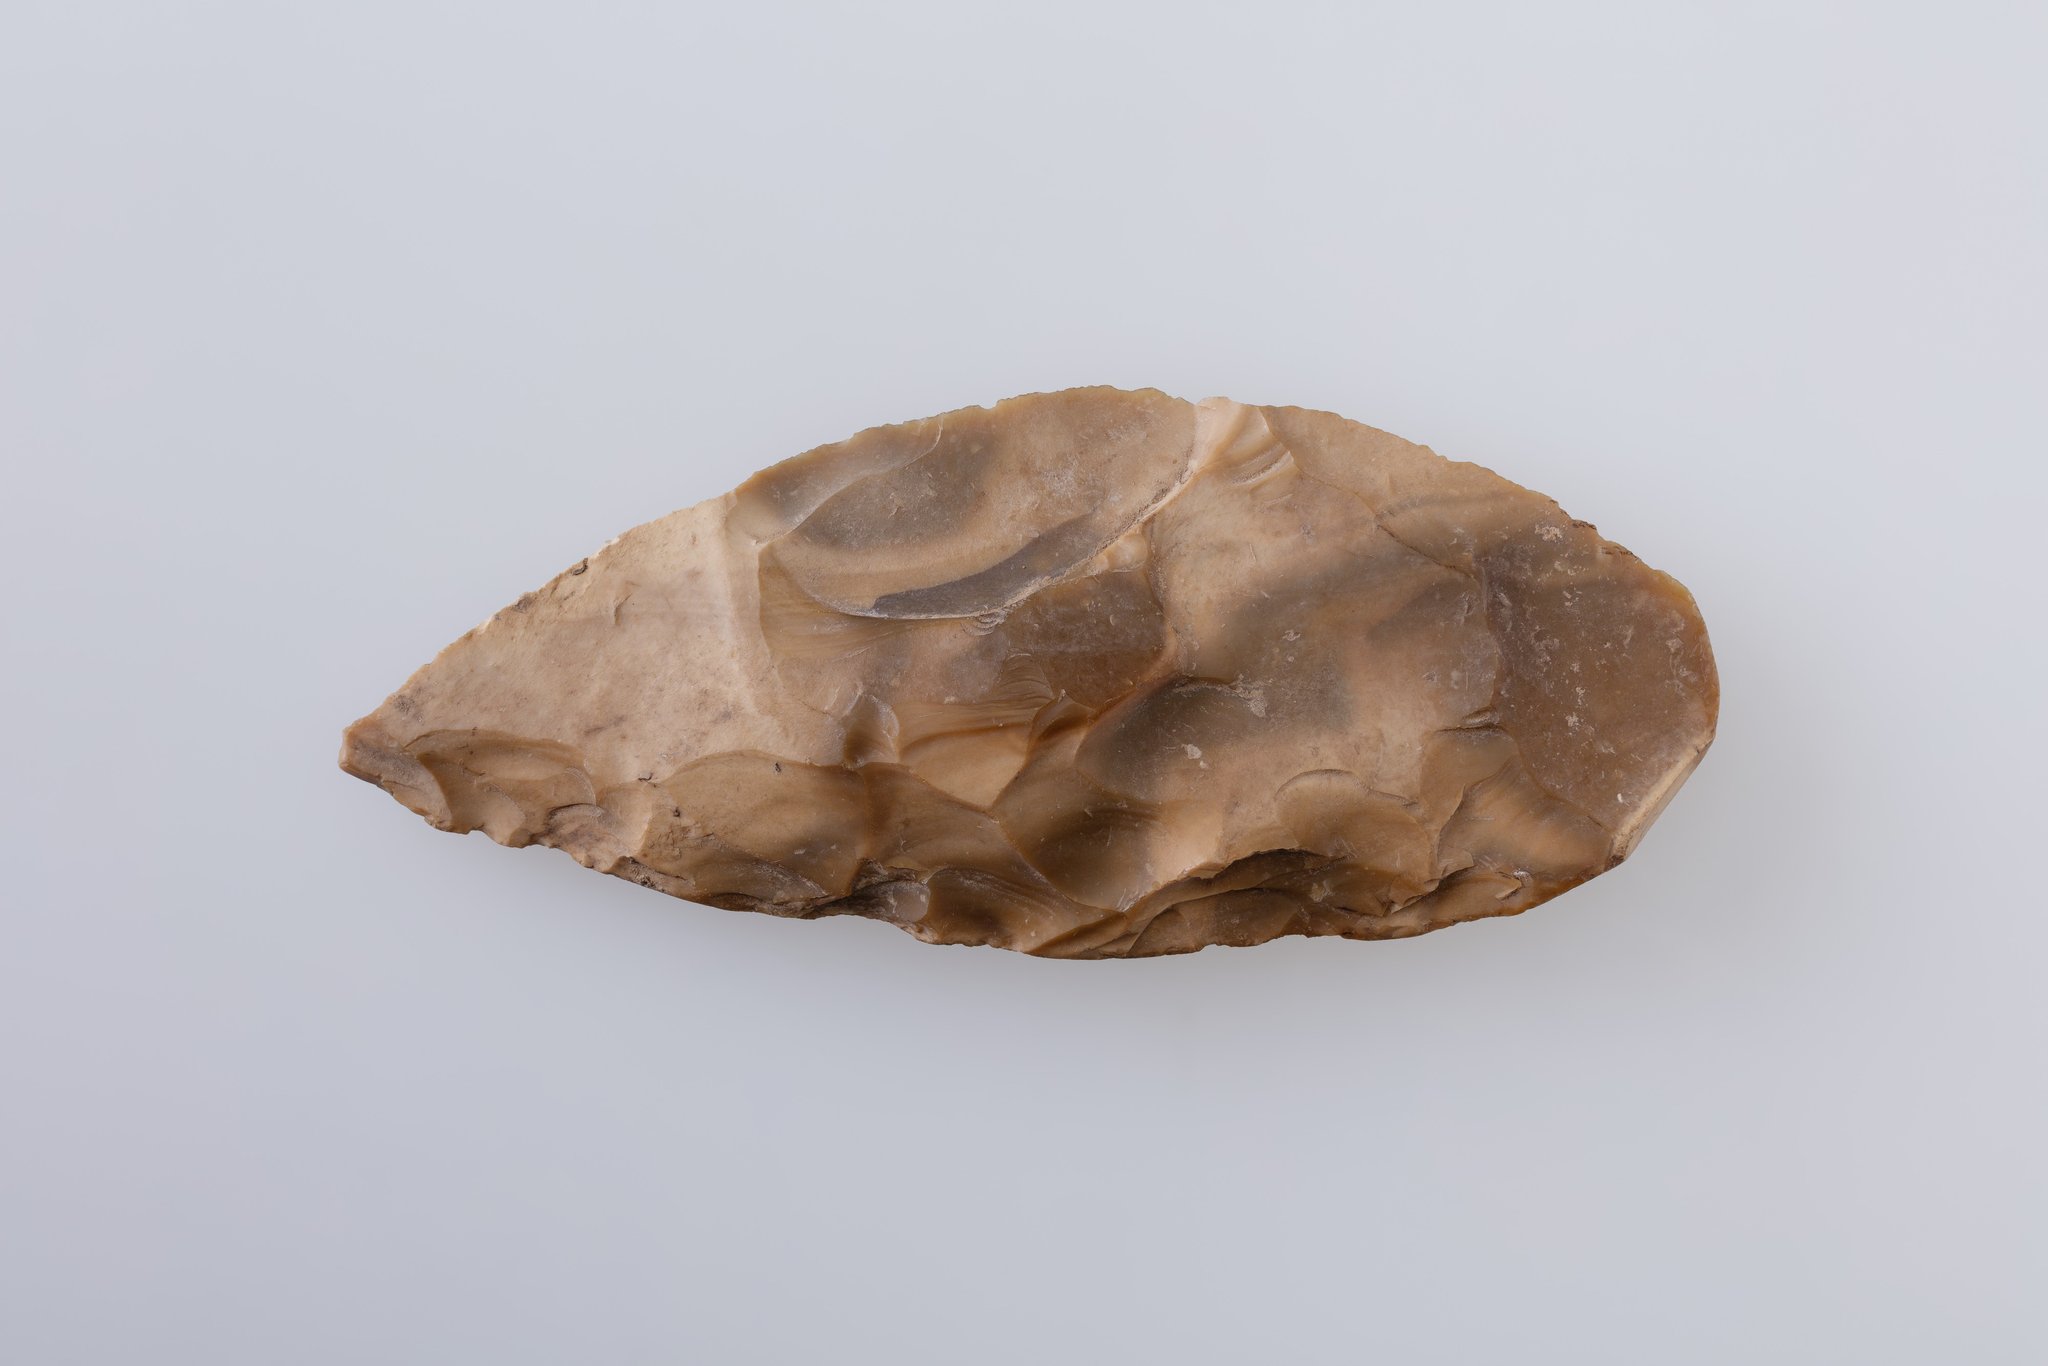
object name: tool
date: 3100-2649 BCE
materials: stone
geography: egypt